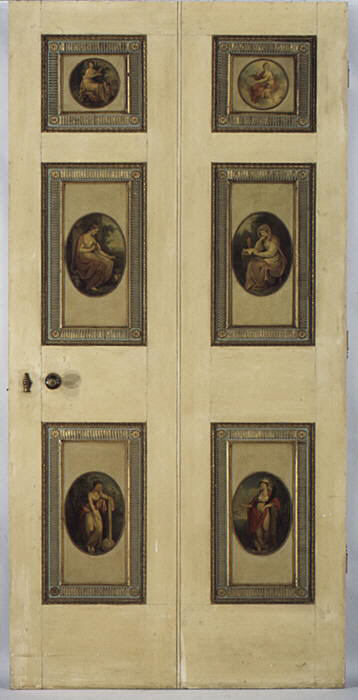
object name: door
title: Pair of doors with scenes after Angelica Kauffman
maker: angelica kauffmann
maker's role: artist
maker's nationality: swiss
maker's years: 1741-1807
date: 1784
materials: copper, gilt bronze, wood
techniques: polychrome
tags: women